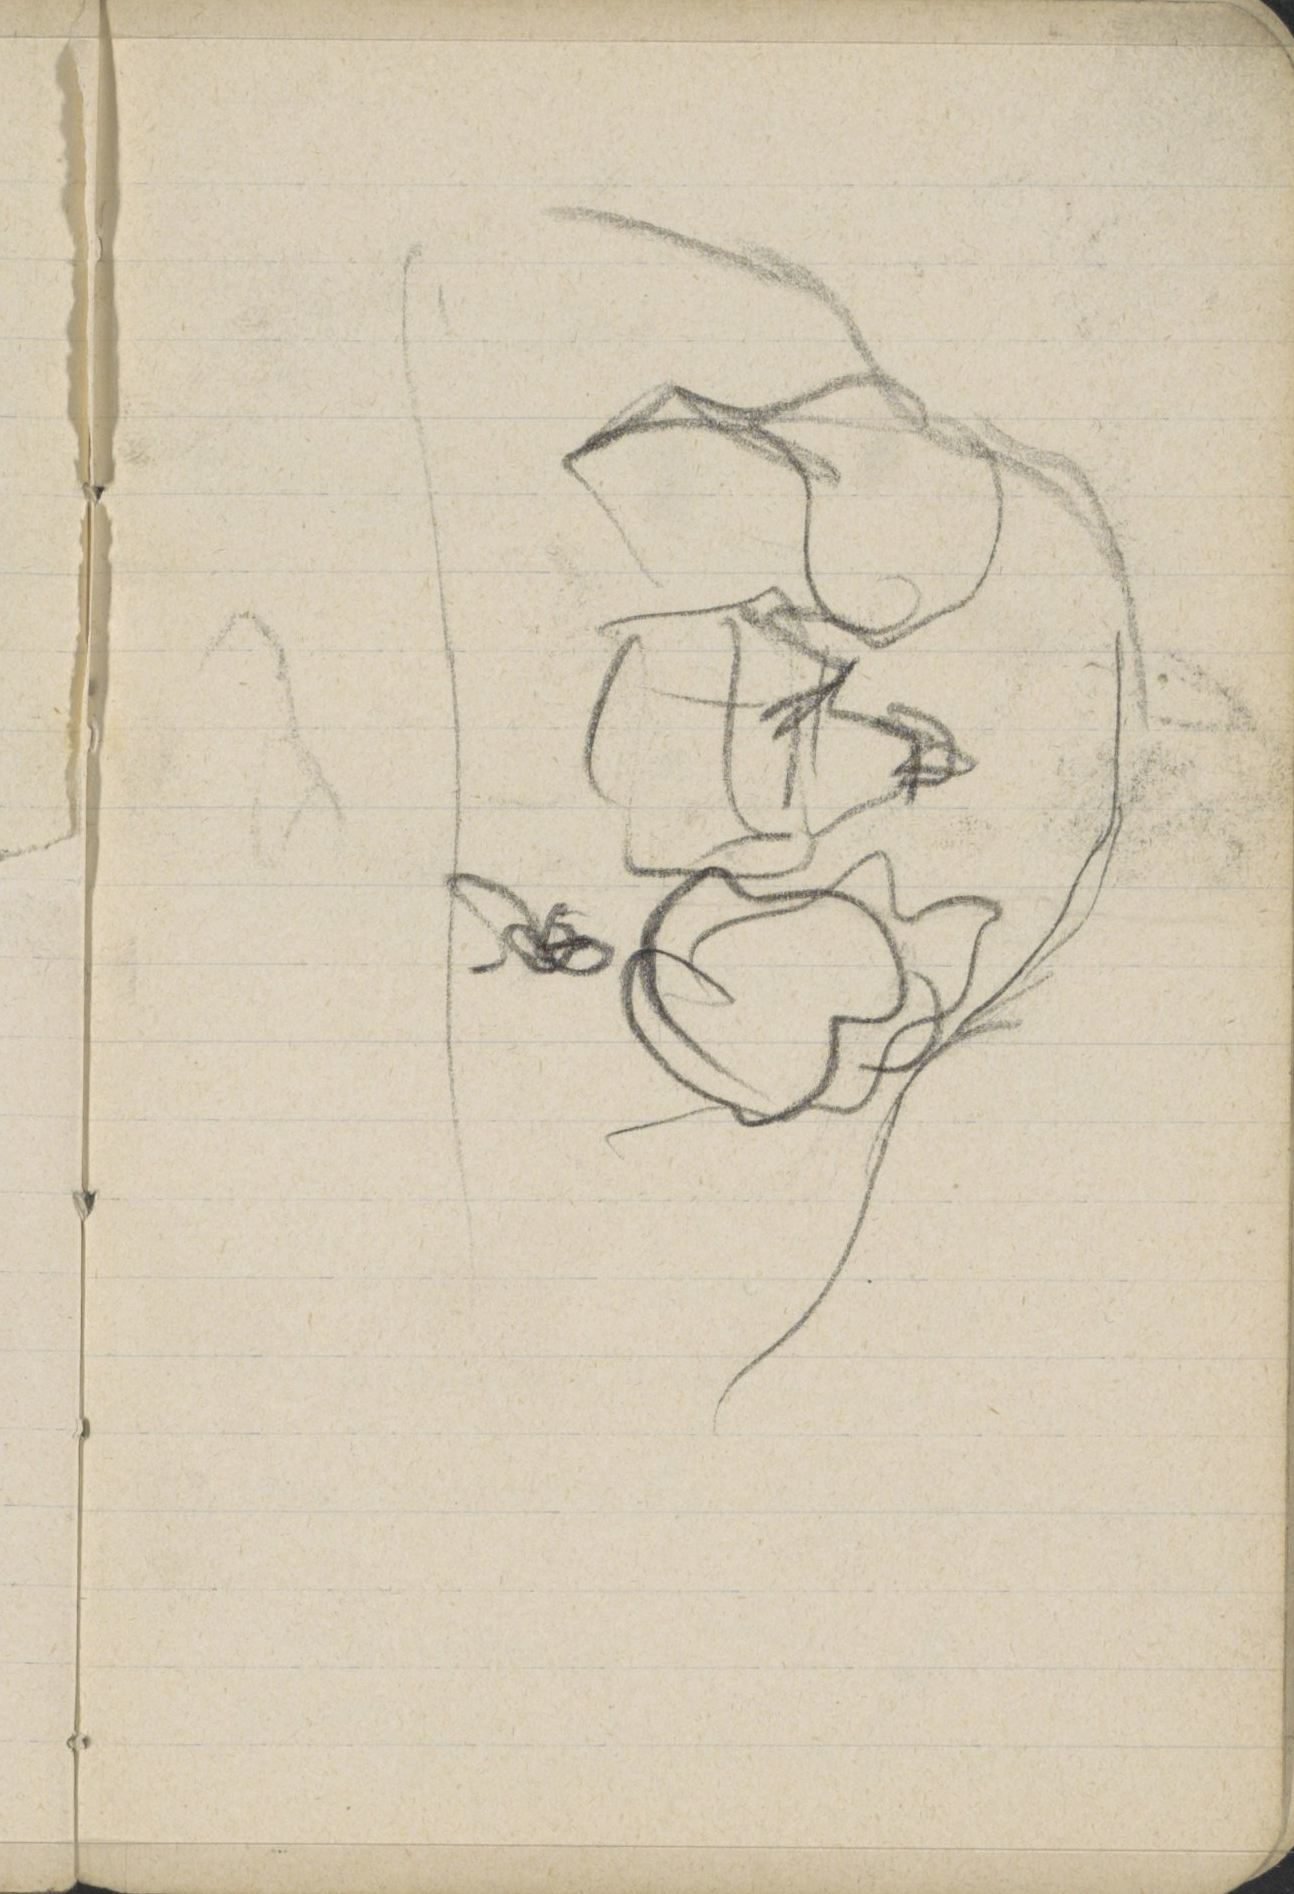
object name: sketchbook leaf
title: Studie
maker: george hendrik breitner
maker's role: draughtsman, painter, print maker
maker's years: 1857-1923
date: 1903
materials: chalk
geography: amsterdam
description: Pagina 78 uit een schetsboek met 32 bladen.